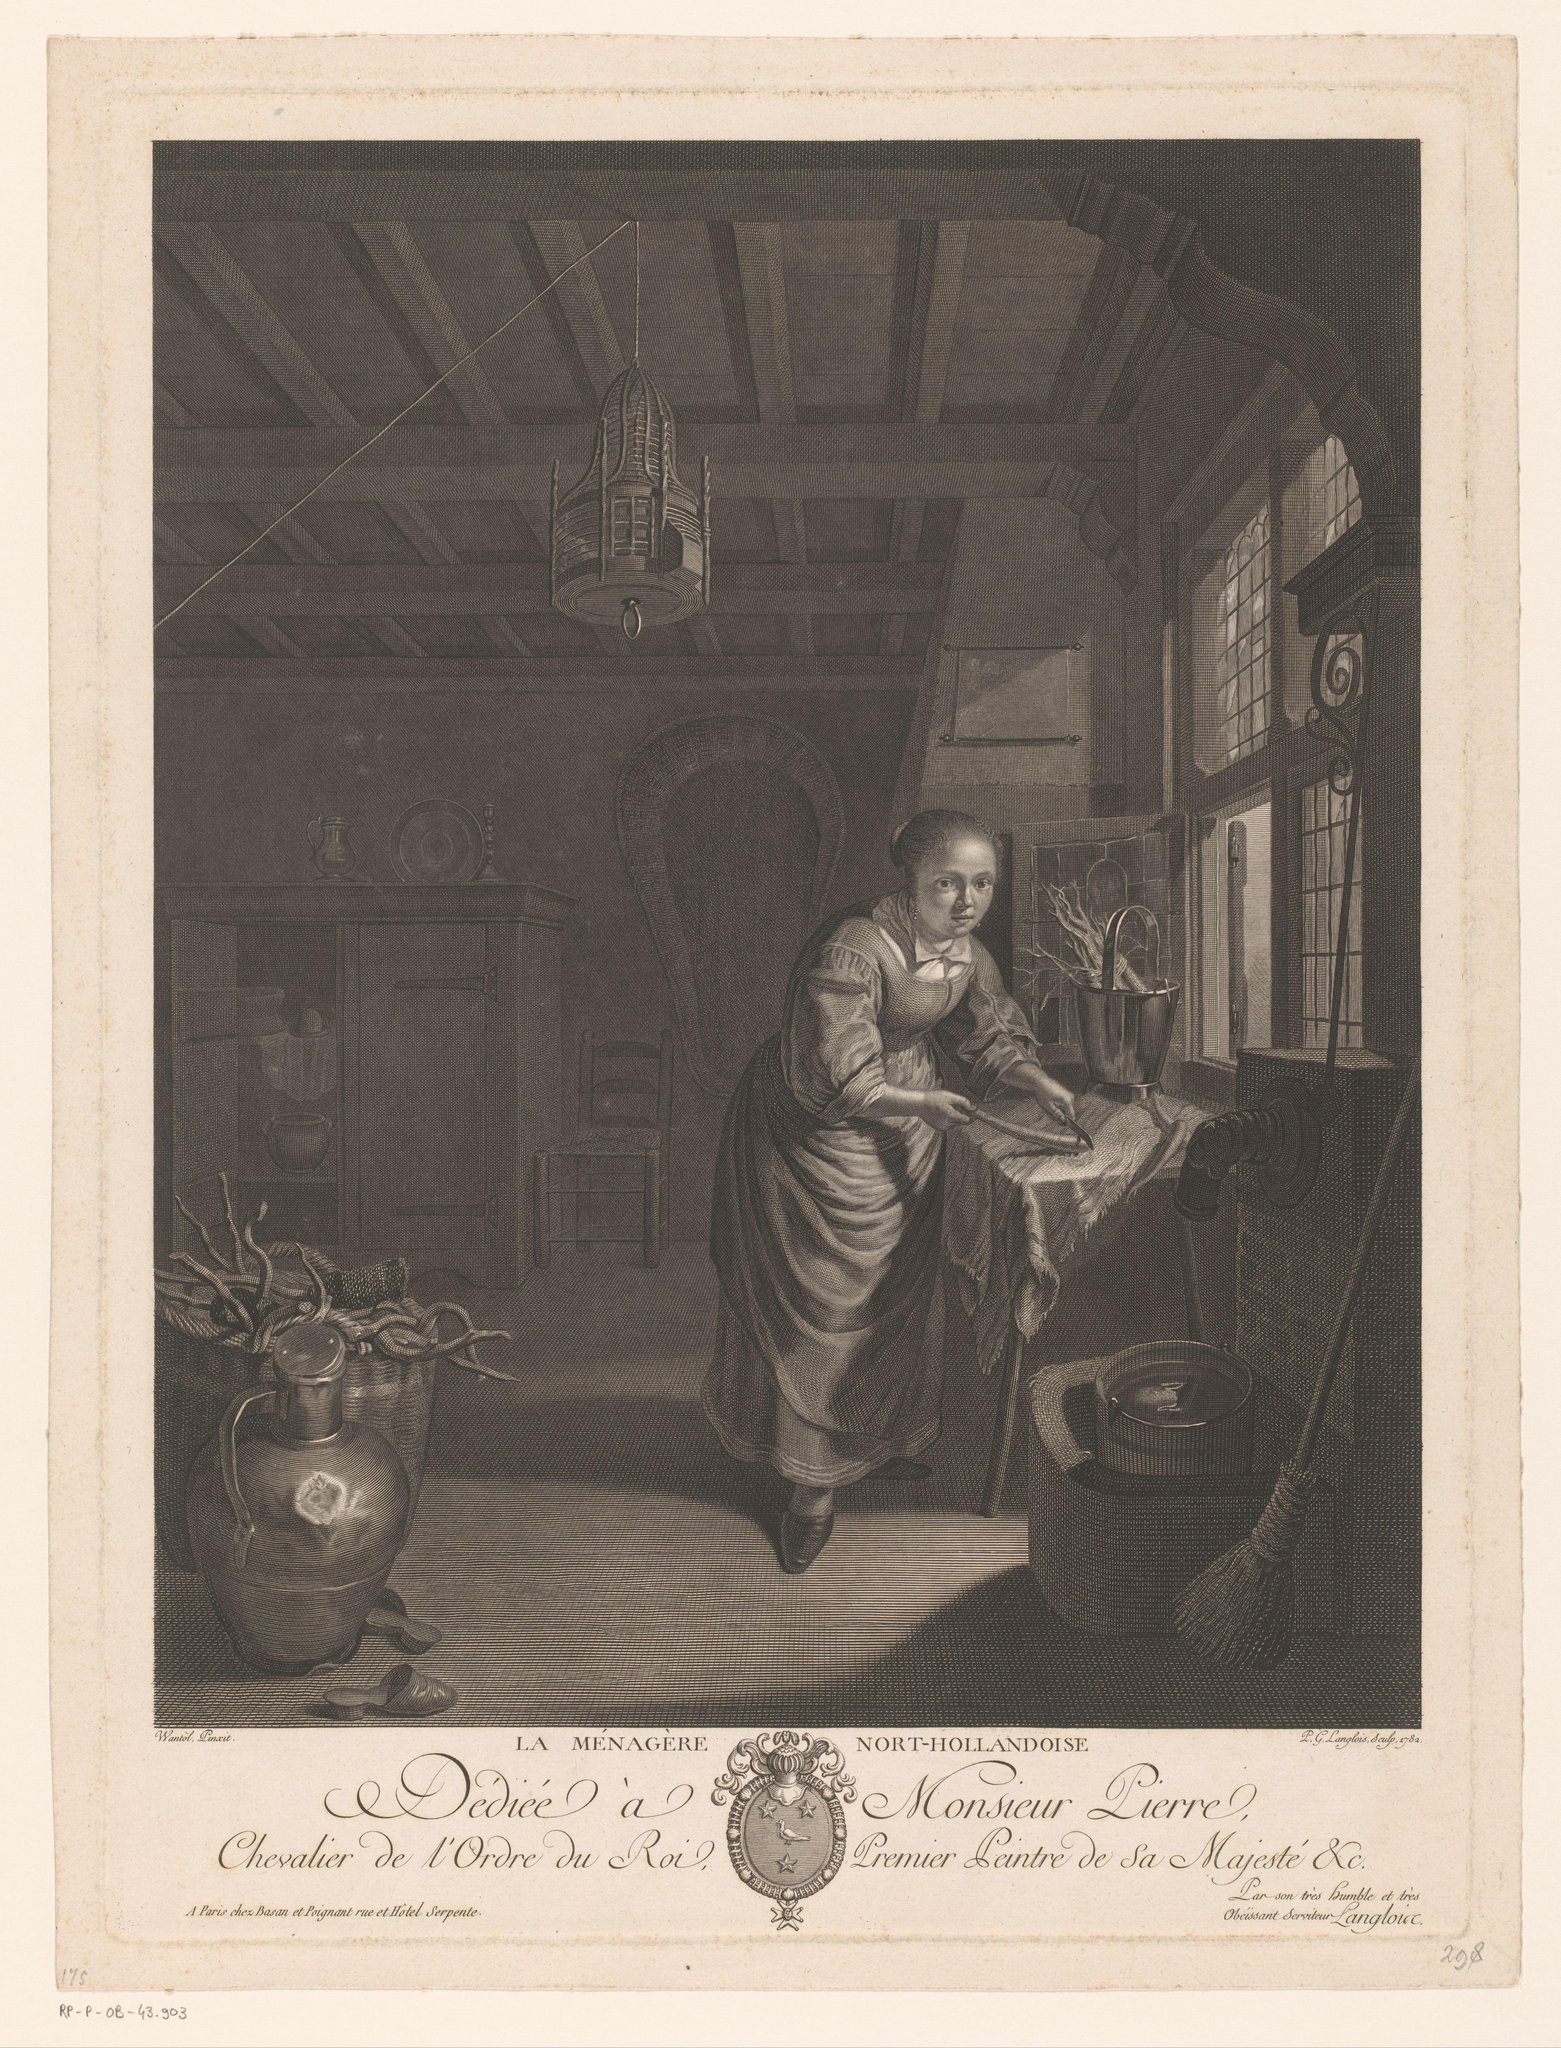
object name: print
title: La Ménagère Nort-Hollandoise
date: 1782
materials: paper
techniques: engraving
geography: paris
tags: kitchen-interior, kitchen-maid, kitchen servant, armorial bearing, heraldry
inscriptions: collector's mark: Lugt 2228